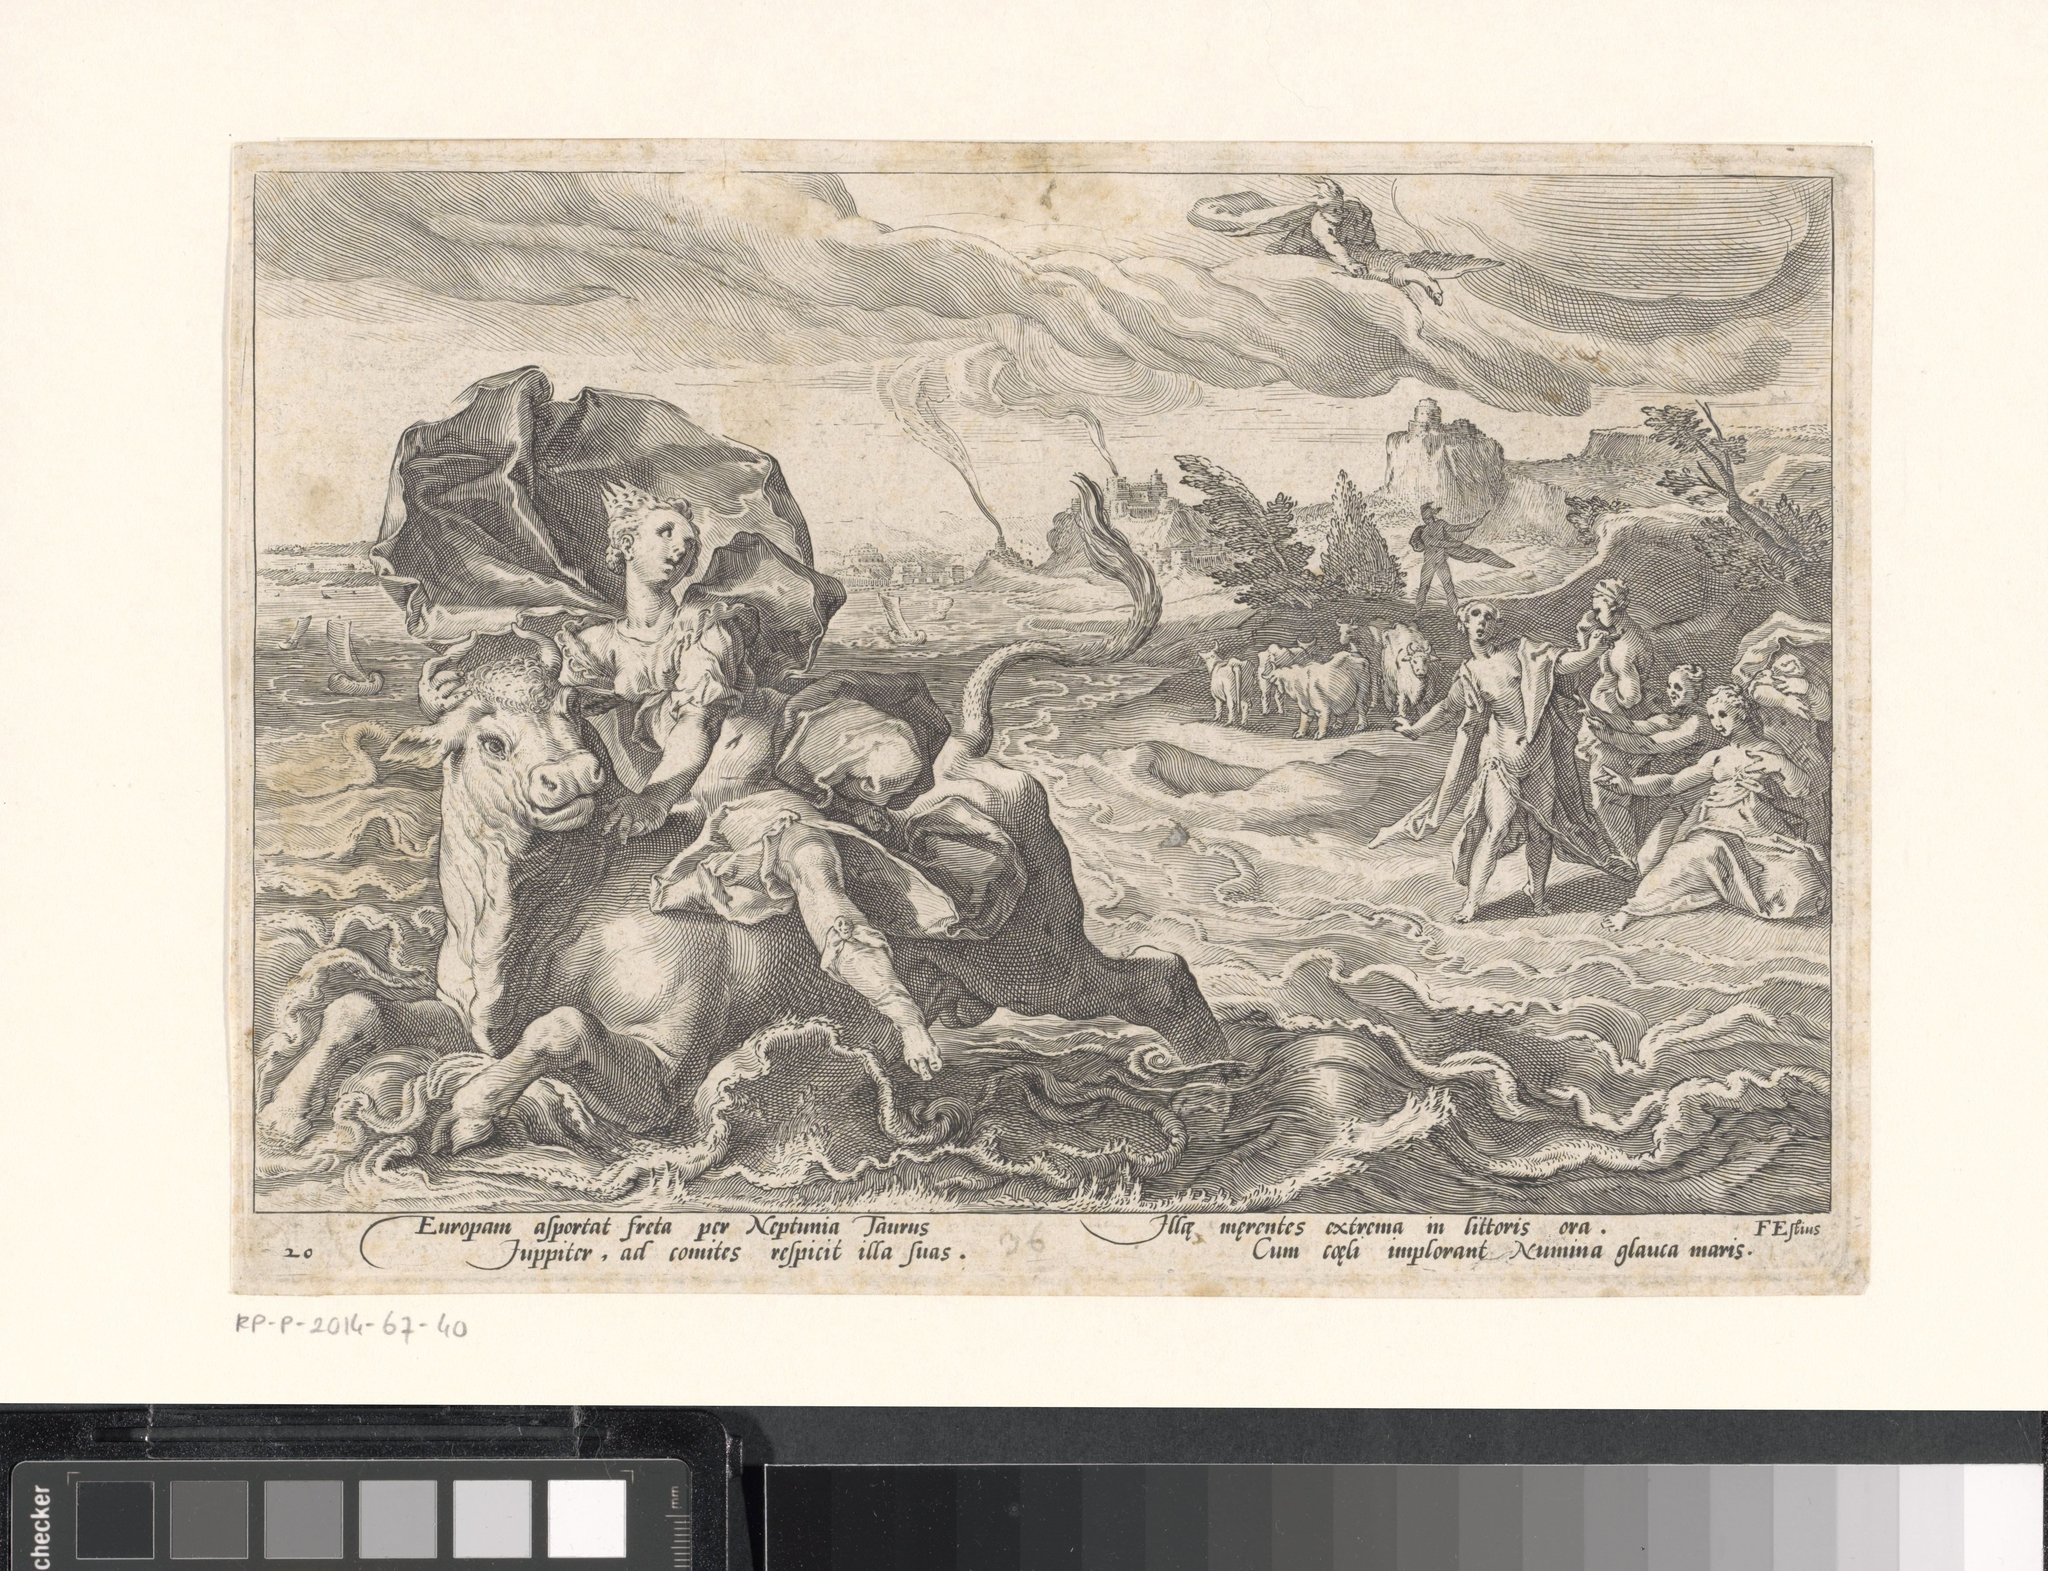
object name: print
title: Metamorfosen van Ovidius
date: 1590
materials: paper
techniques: engraving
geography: haarlem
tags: jupiter, usually in the shape of a white bull, abducts europa and carries her across the water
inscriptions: collector's mark: Lugt 11, collector's mark: ‘Hinloopen’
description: Jupiter, in de gedaante van een witte stier, voert Europa weg door de zee. Haar wanhopige dienstmaagden blijven achter op het strand. In de ondermarge een vierregelige toelichting, in twee kolommen, in het Latijn.